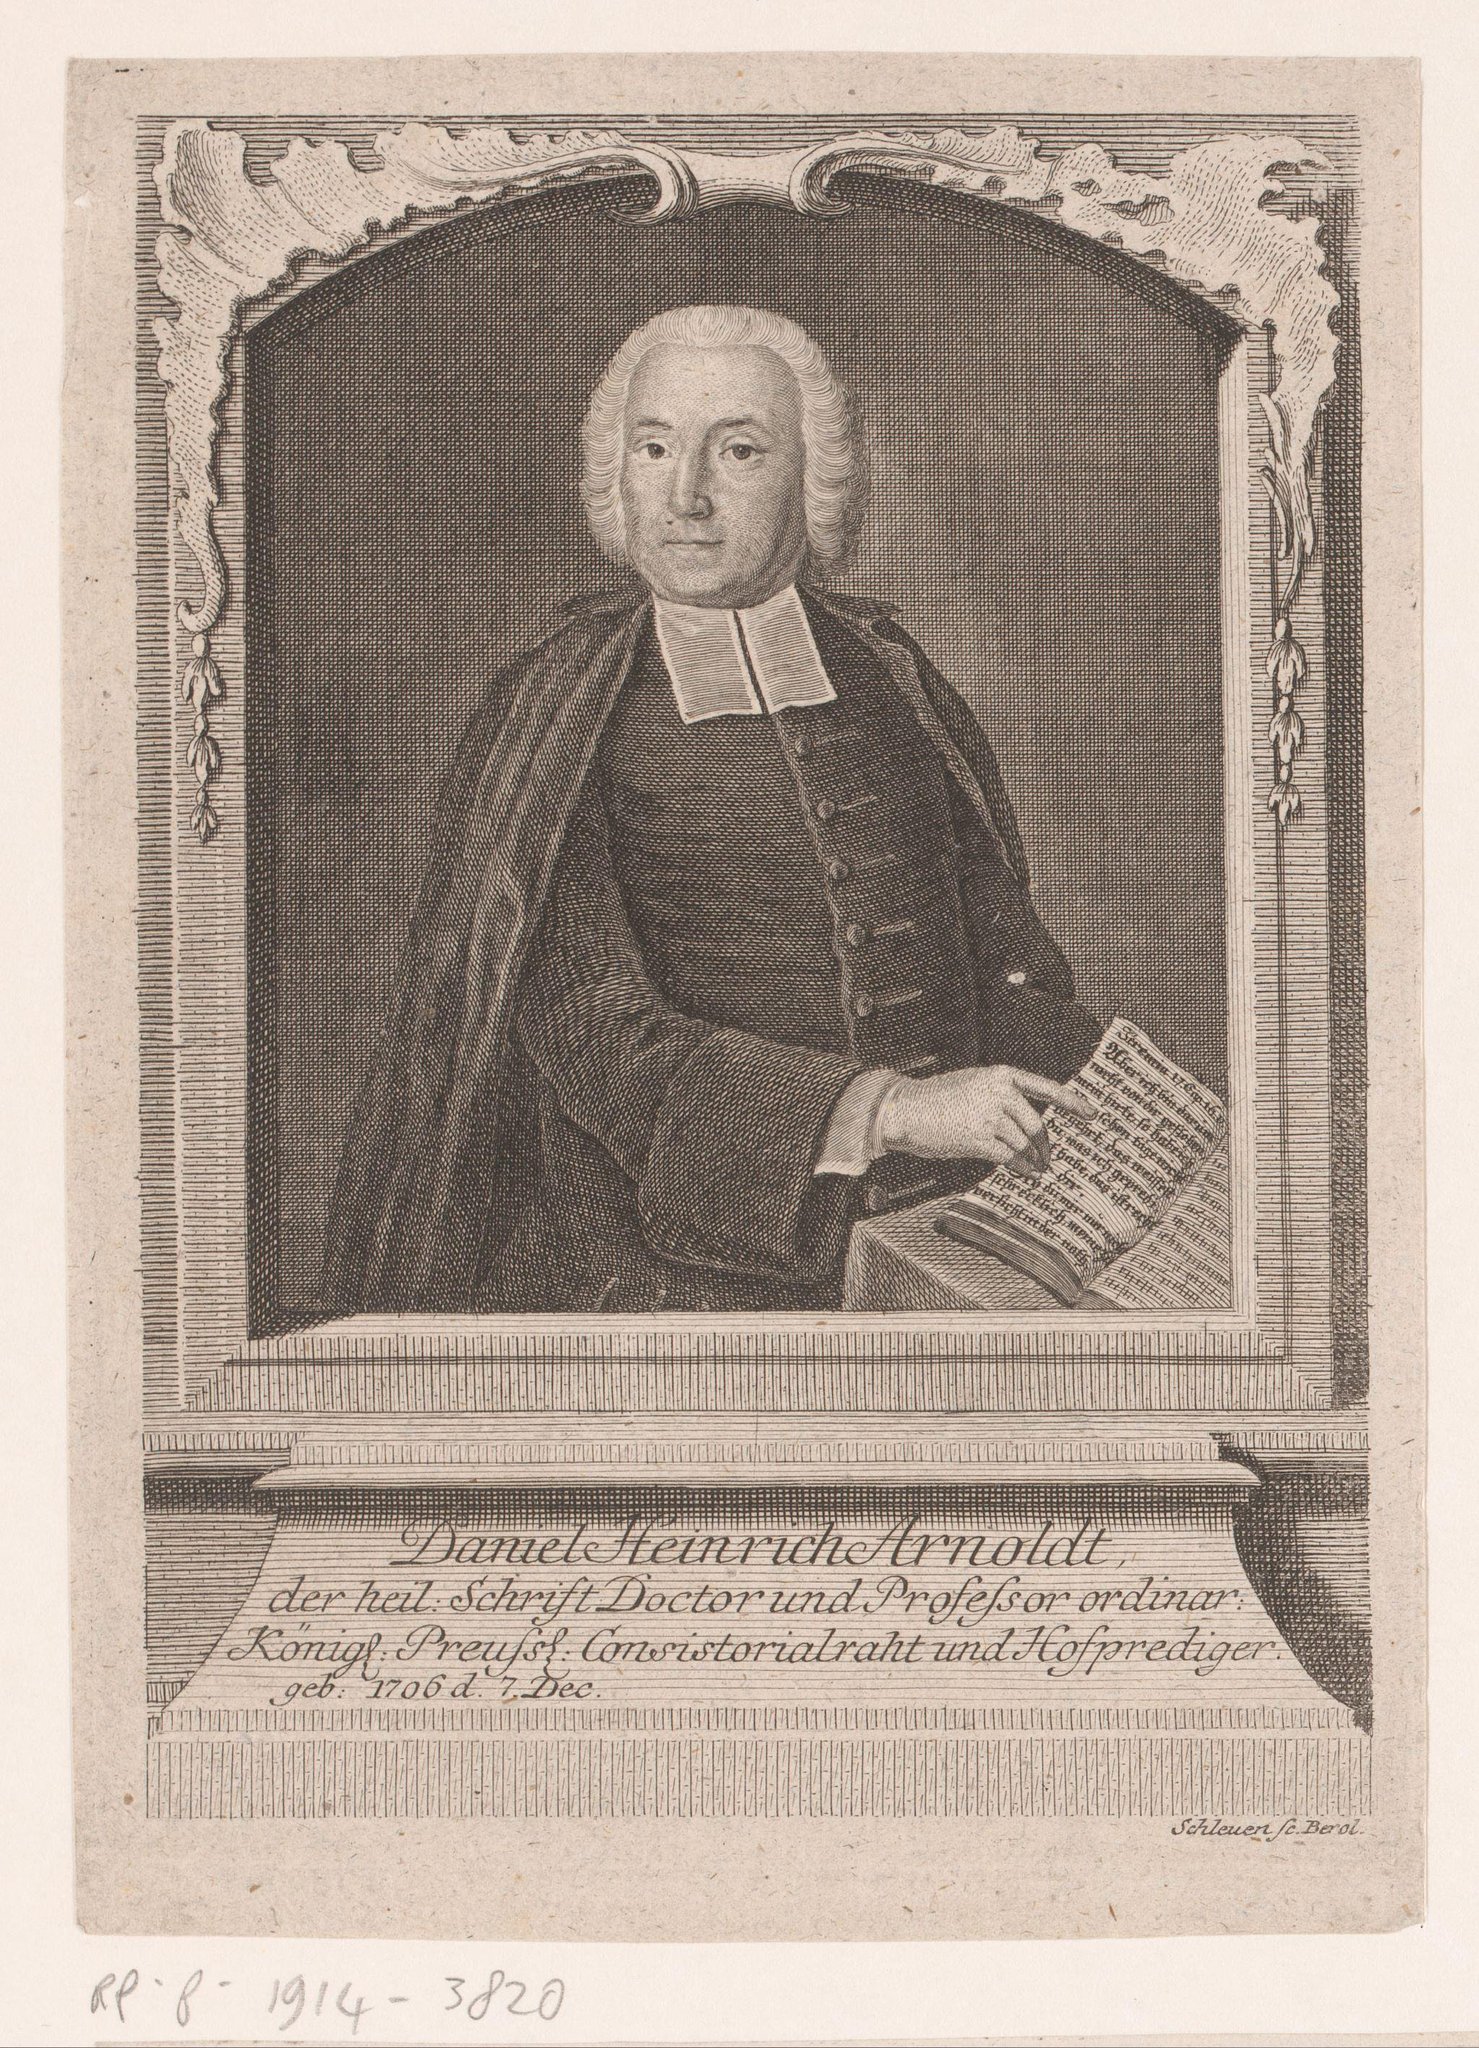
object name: print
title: Portret van Daniel Heinrich Arnoldt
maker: johann david schleuen (i)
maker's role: print maker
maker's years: 1711-1774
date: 1721-1771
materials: paper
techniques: engraving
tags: theologian, historical persons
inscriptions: collector's mark: Lugt 2228